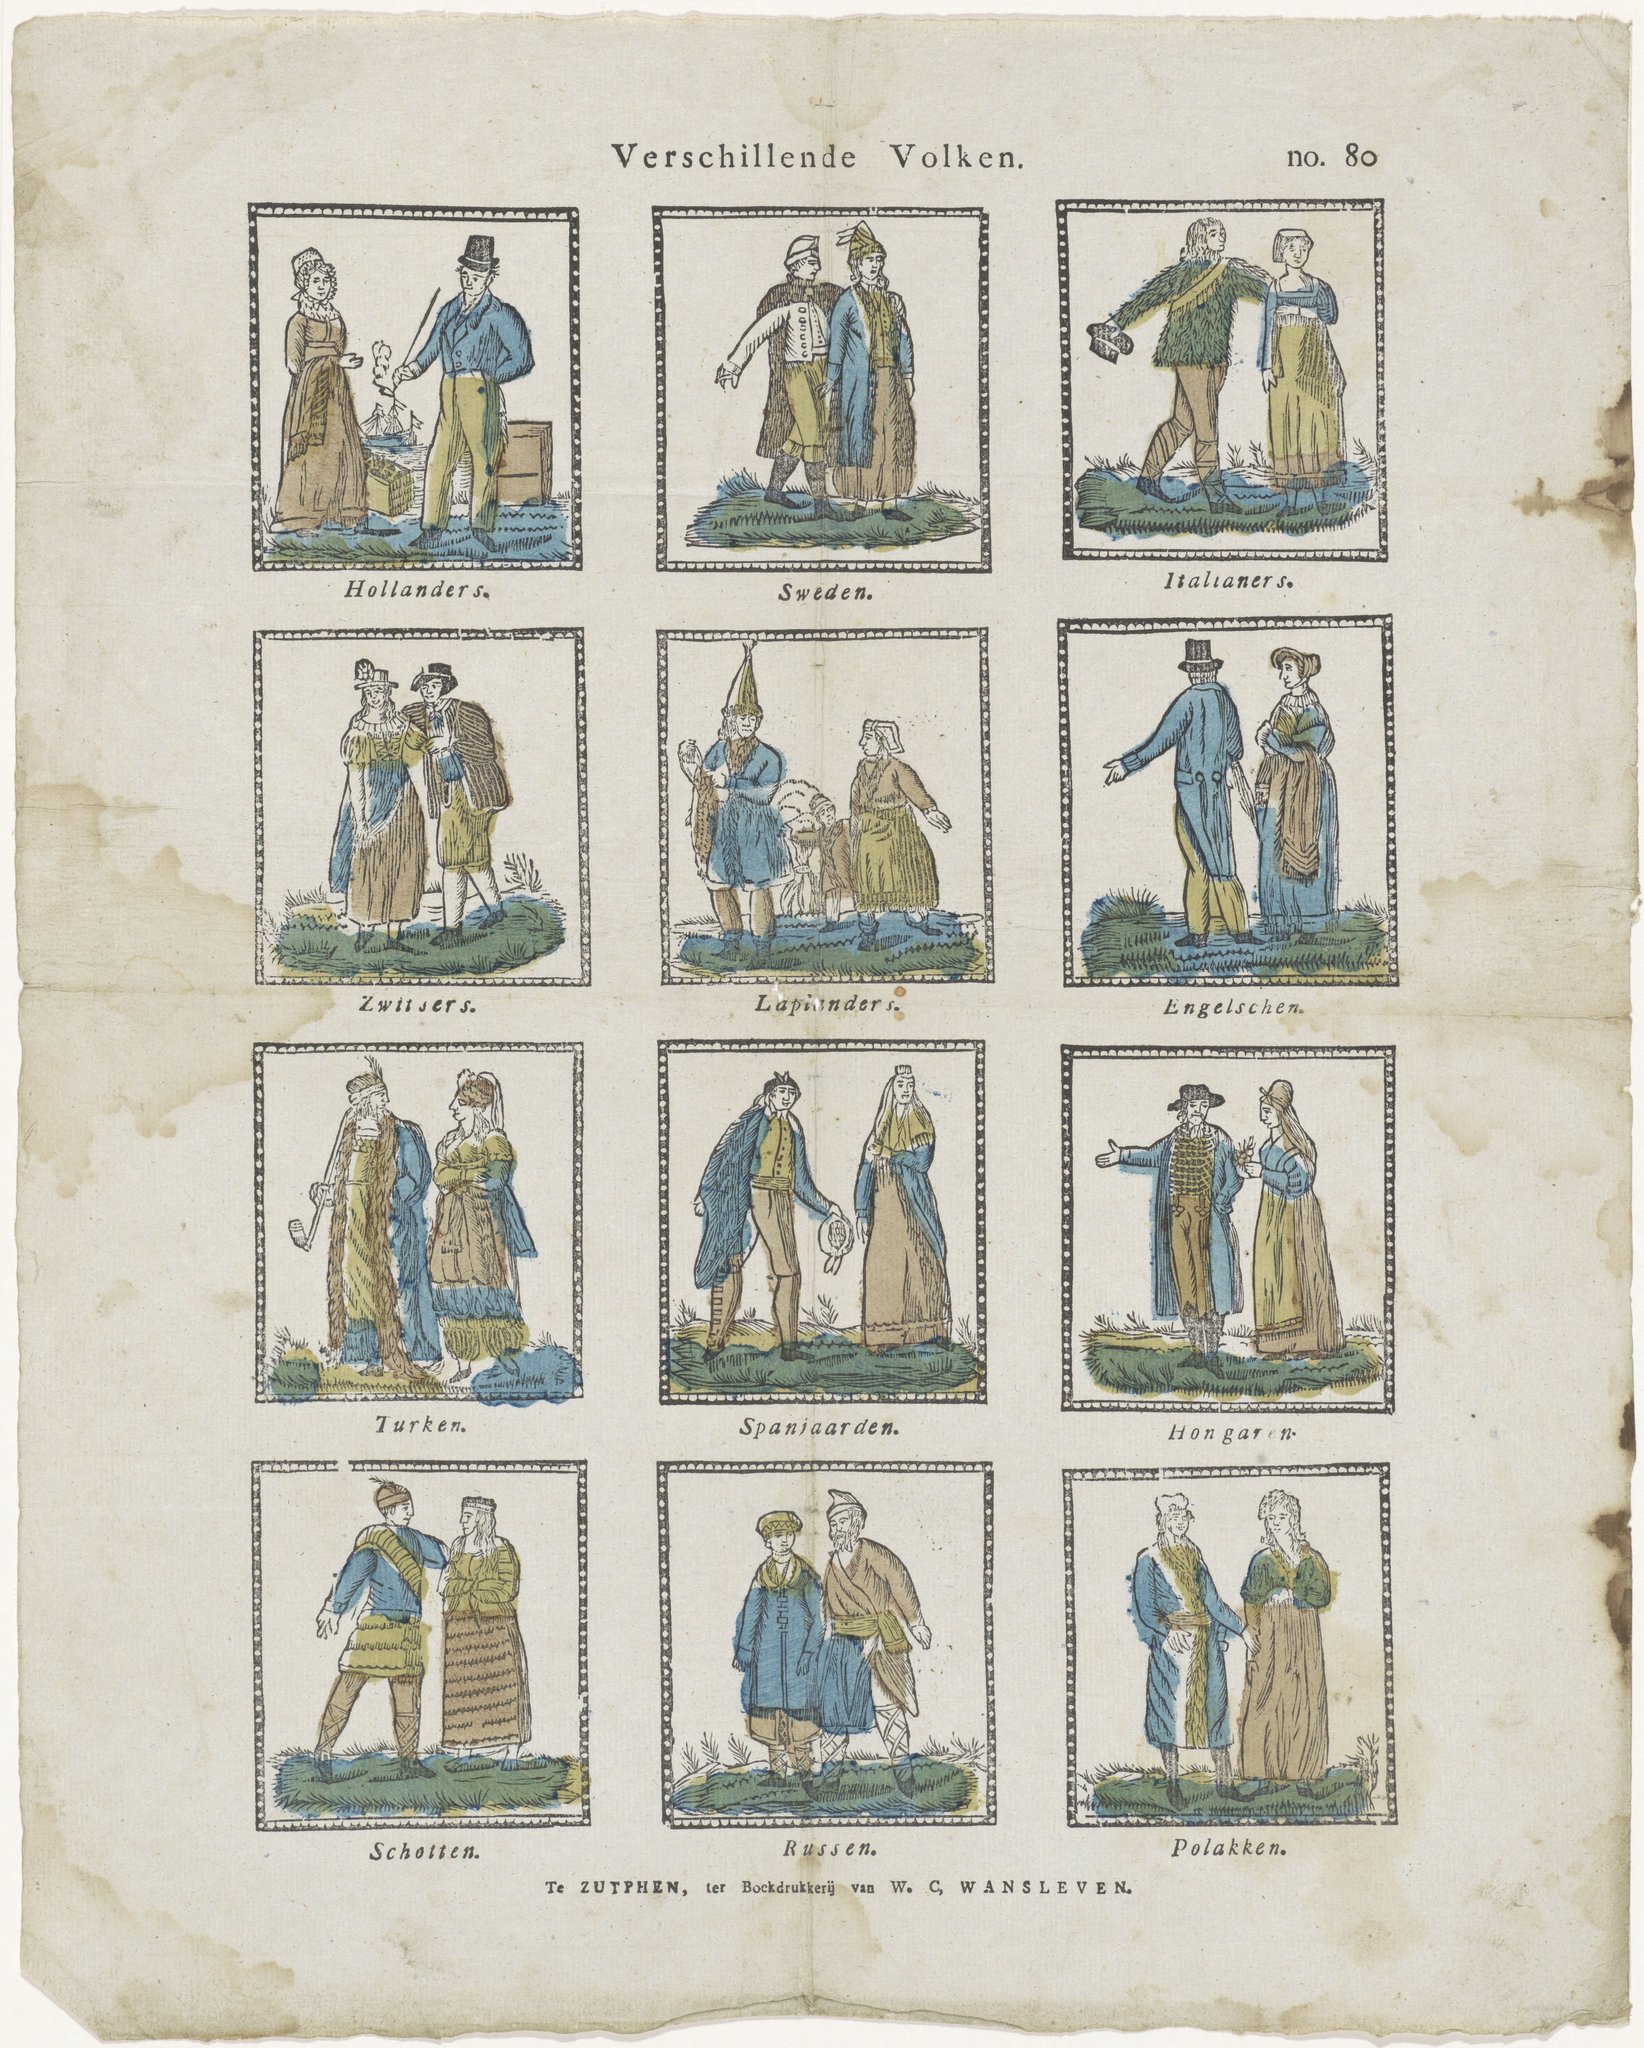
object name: print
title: Verschillende volken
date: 1806-1858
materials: paper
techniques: colour, letterpress printing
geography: zutphen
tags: europeans, asiatic races and peoples: turks, europeans: englishmen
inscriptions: collector's mark: Lugt 2228, collector's mark: Lugt 2760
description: Blad met 12 voorstellingen van paren van verschillende volken, waaronder Hollanders, Zweden, Engelsen en Polen. Onder elke afbeelding een onderschrift. Genummerd rechtsboven: no. 80.